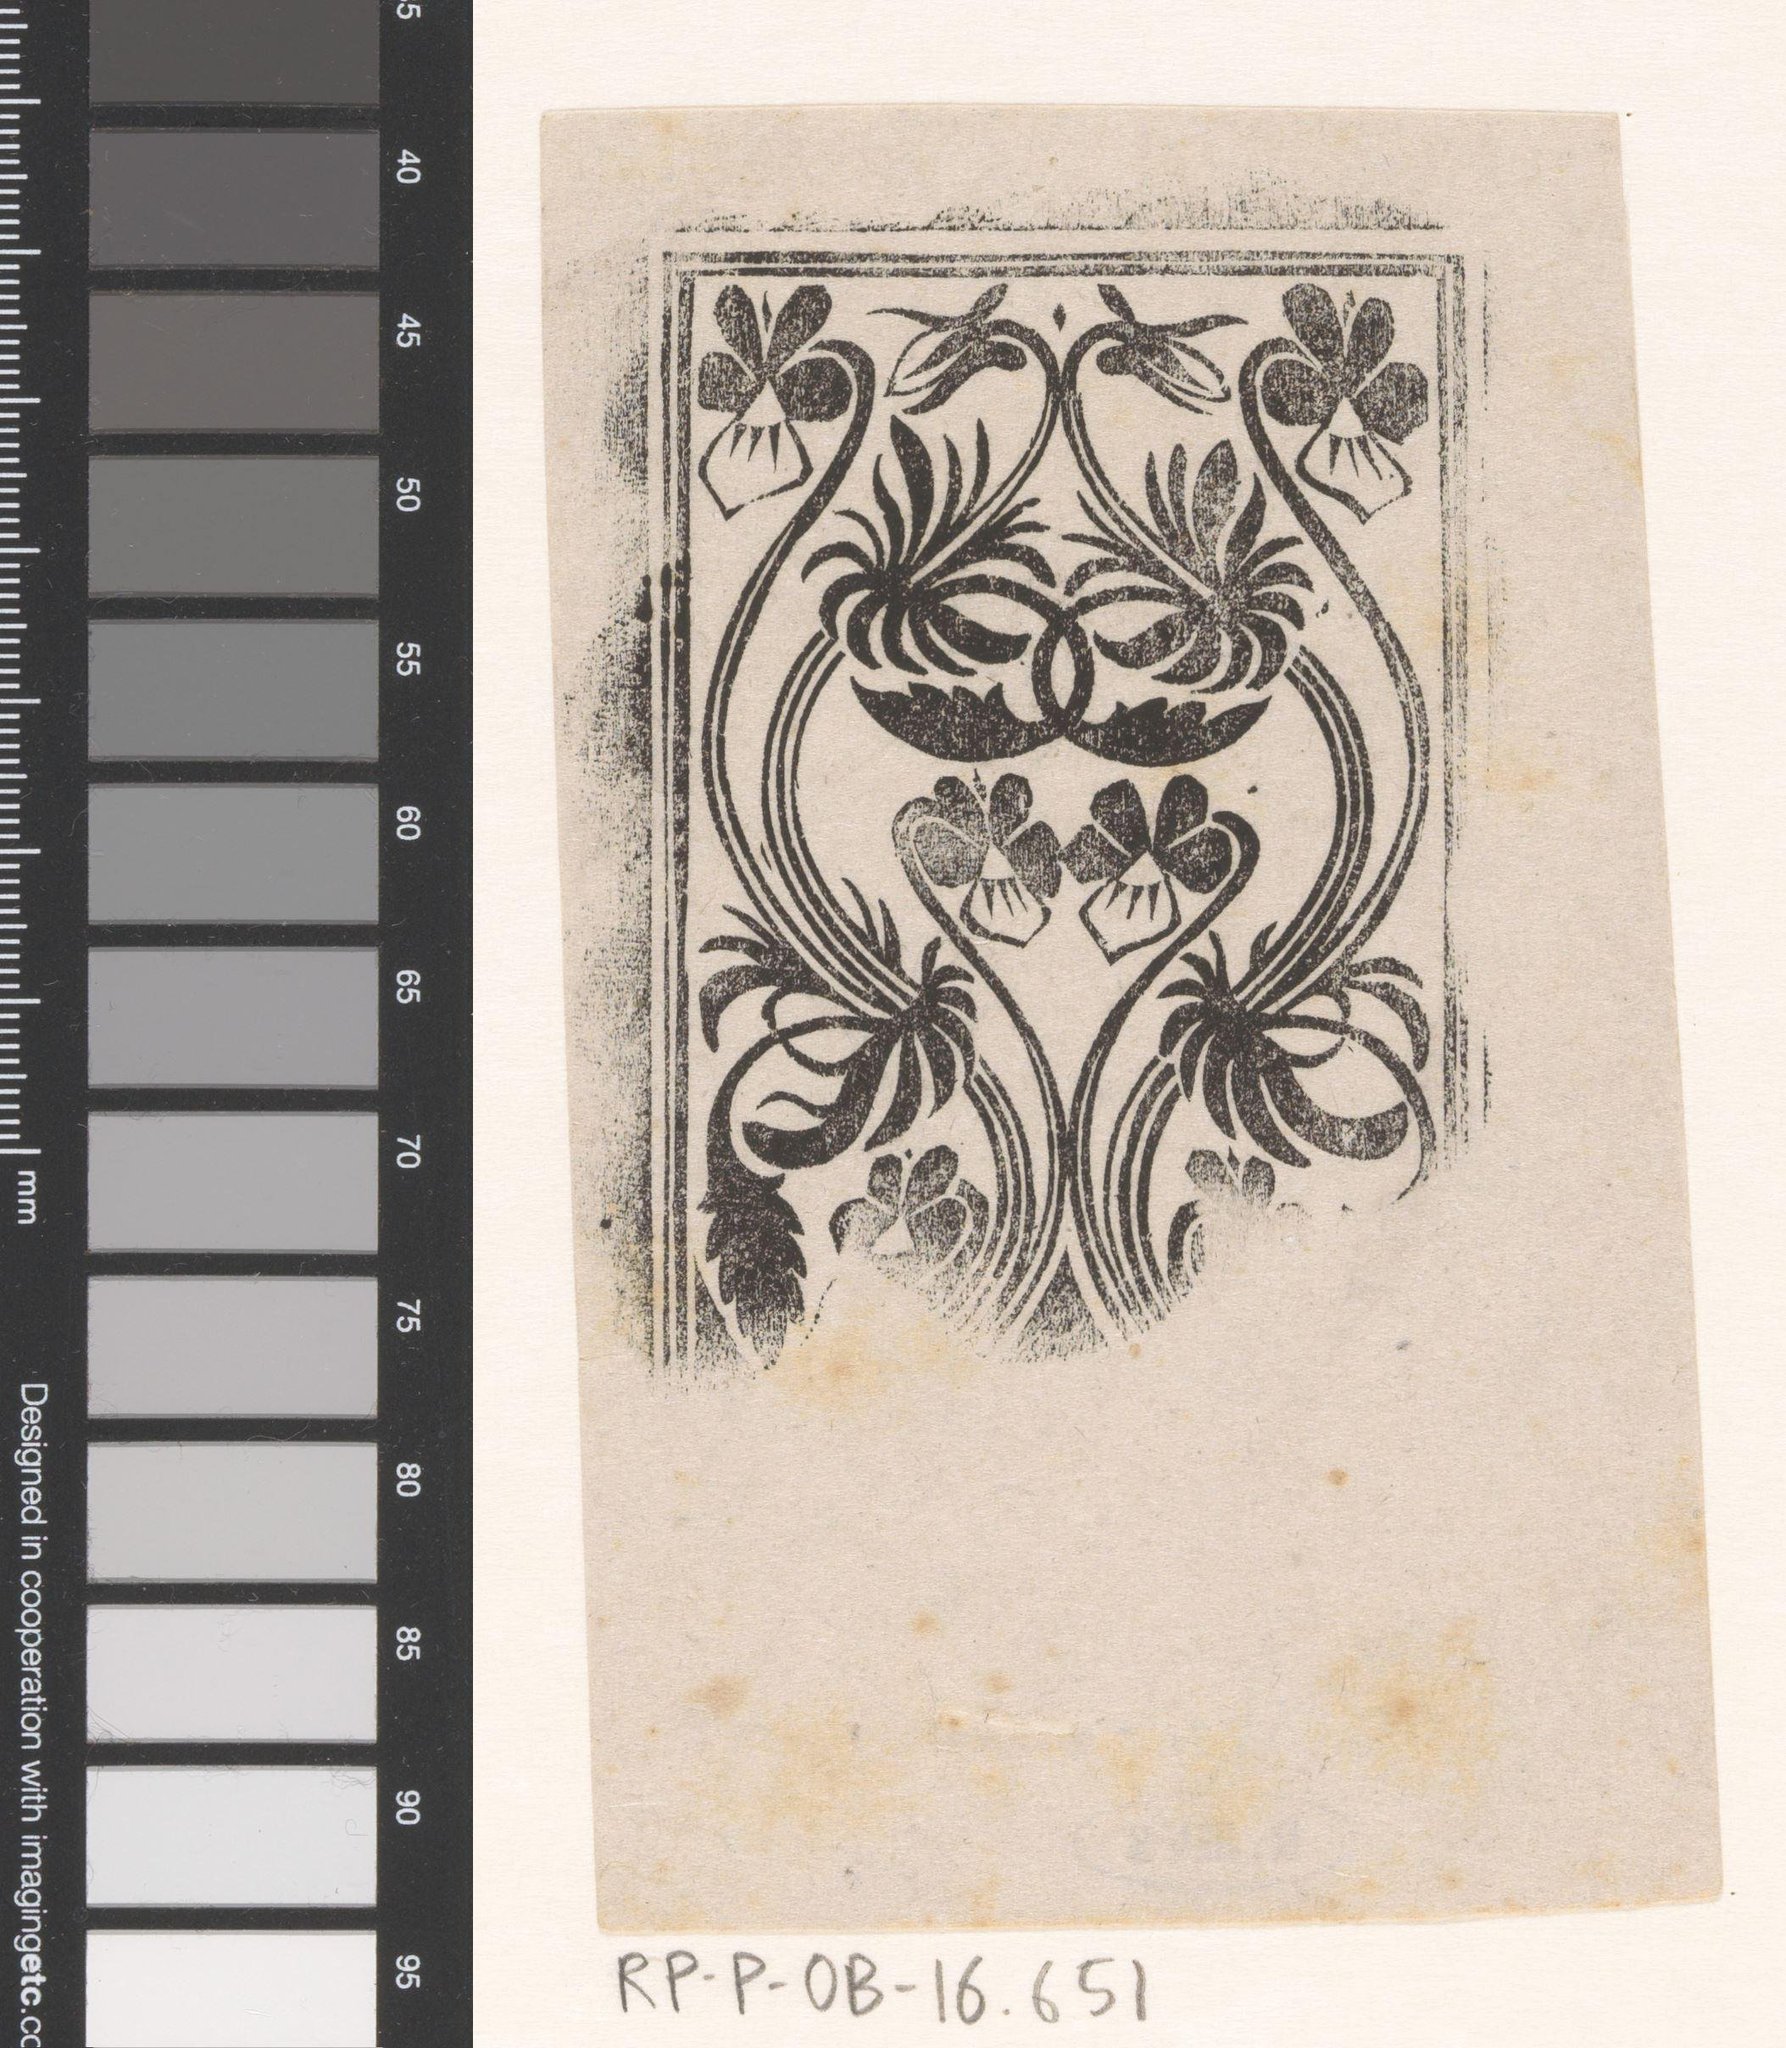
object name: print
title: Bosviolen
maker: gerrit willem dijsselhof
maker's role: designer, draughtsman, print maker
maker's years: 1866-1924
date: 1876-1924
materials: paper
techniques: woodcut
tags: flowers: violet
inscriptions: collector's mark: Lugt 2228